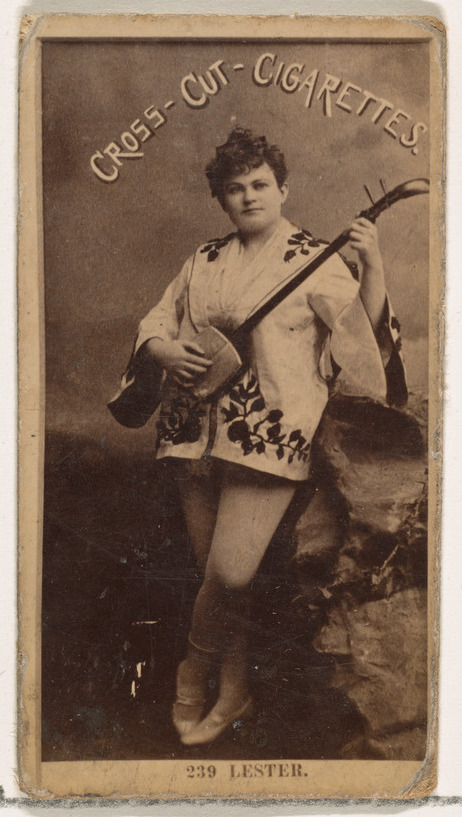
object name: print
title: Card Number 239, Lester, from the Actors and Actresses series (N145-2) issued by Duke Sons & Co. to promote Cross Cut Cigarettes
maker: w. duke, sons & co.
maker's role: publisher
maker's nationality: american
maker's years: 1870-1920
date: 1880-1889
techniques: albumen silver print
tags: portraits,women,actresses